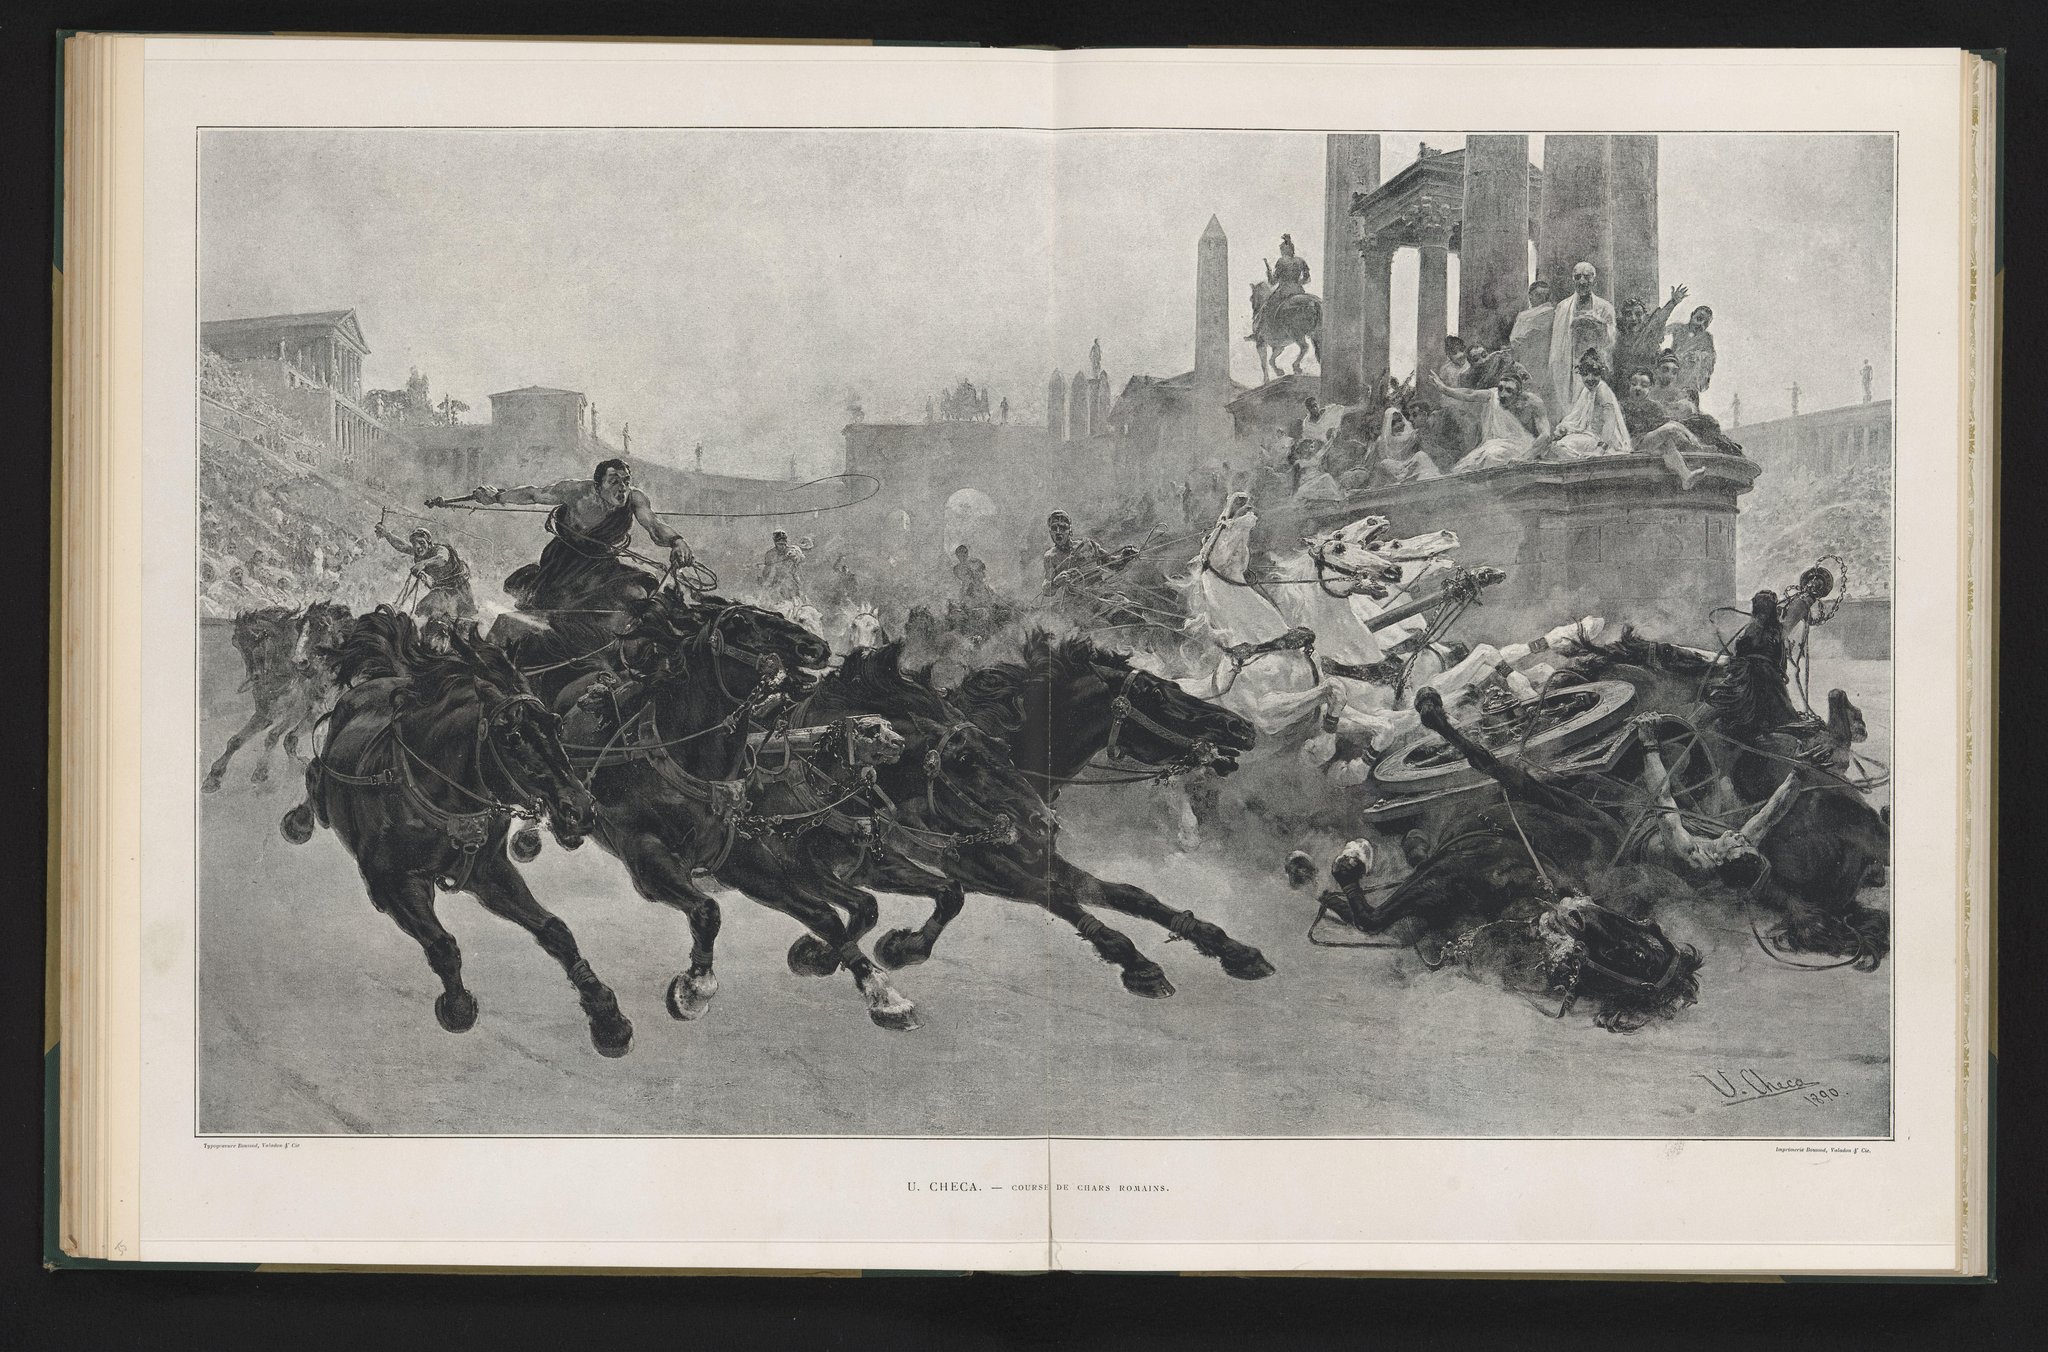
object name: page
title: Reproductie van een schilderij van een race met Romeinse strijdkarren door Ulpiano Checa y Sanz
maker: Anonymous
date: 1885-1901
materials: paper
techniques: two-color autotype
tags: herding, herdsman, herdswoman, shepherd, shepherdess, cowherd, etc., landscapes in the temperate zone (+ landscape with figures, staffage)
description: Prent op pagina 10-11 van Figaro-Salon (par Albert Wolff).